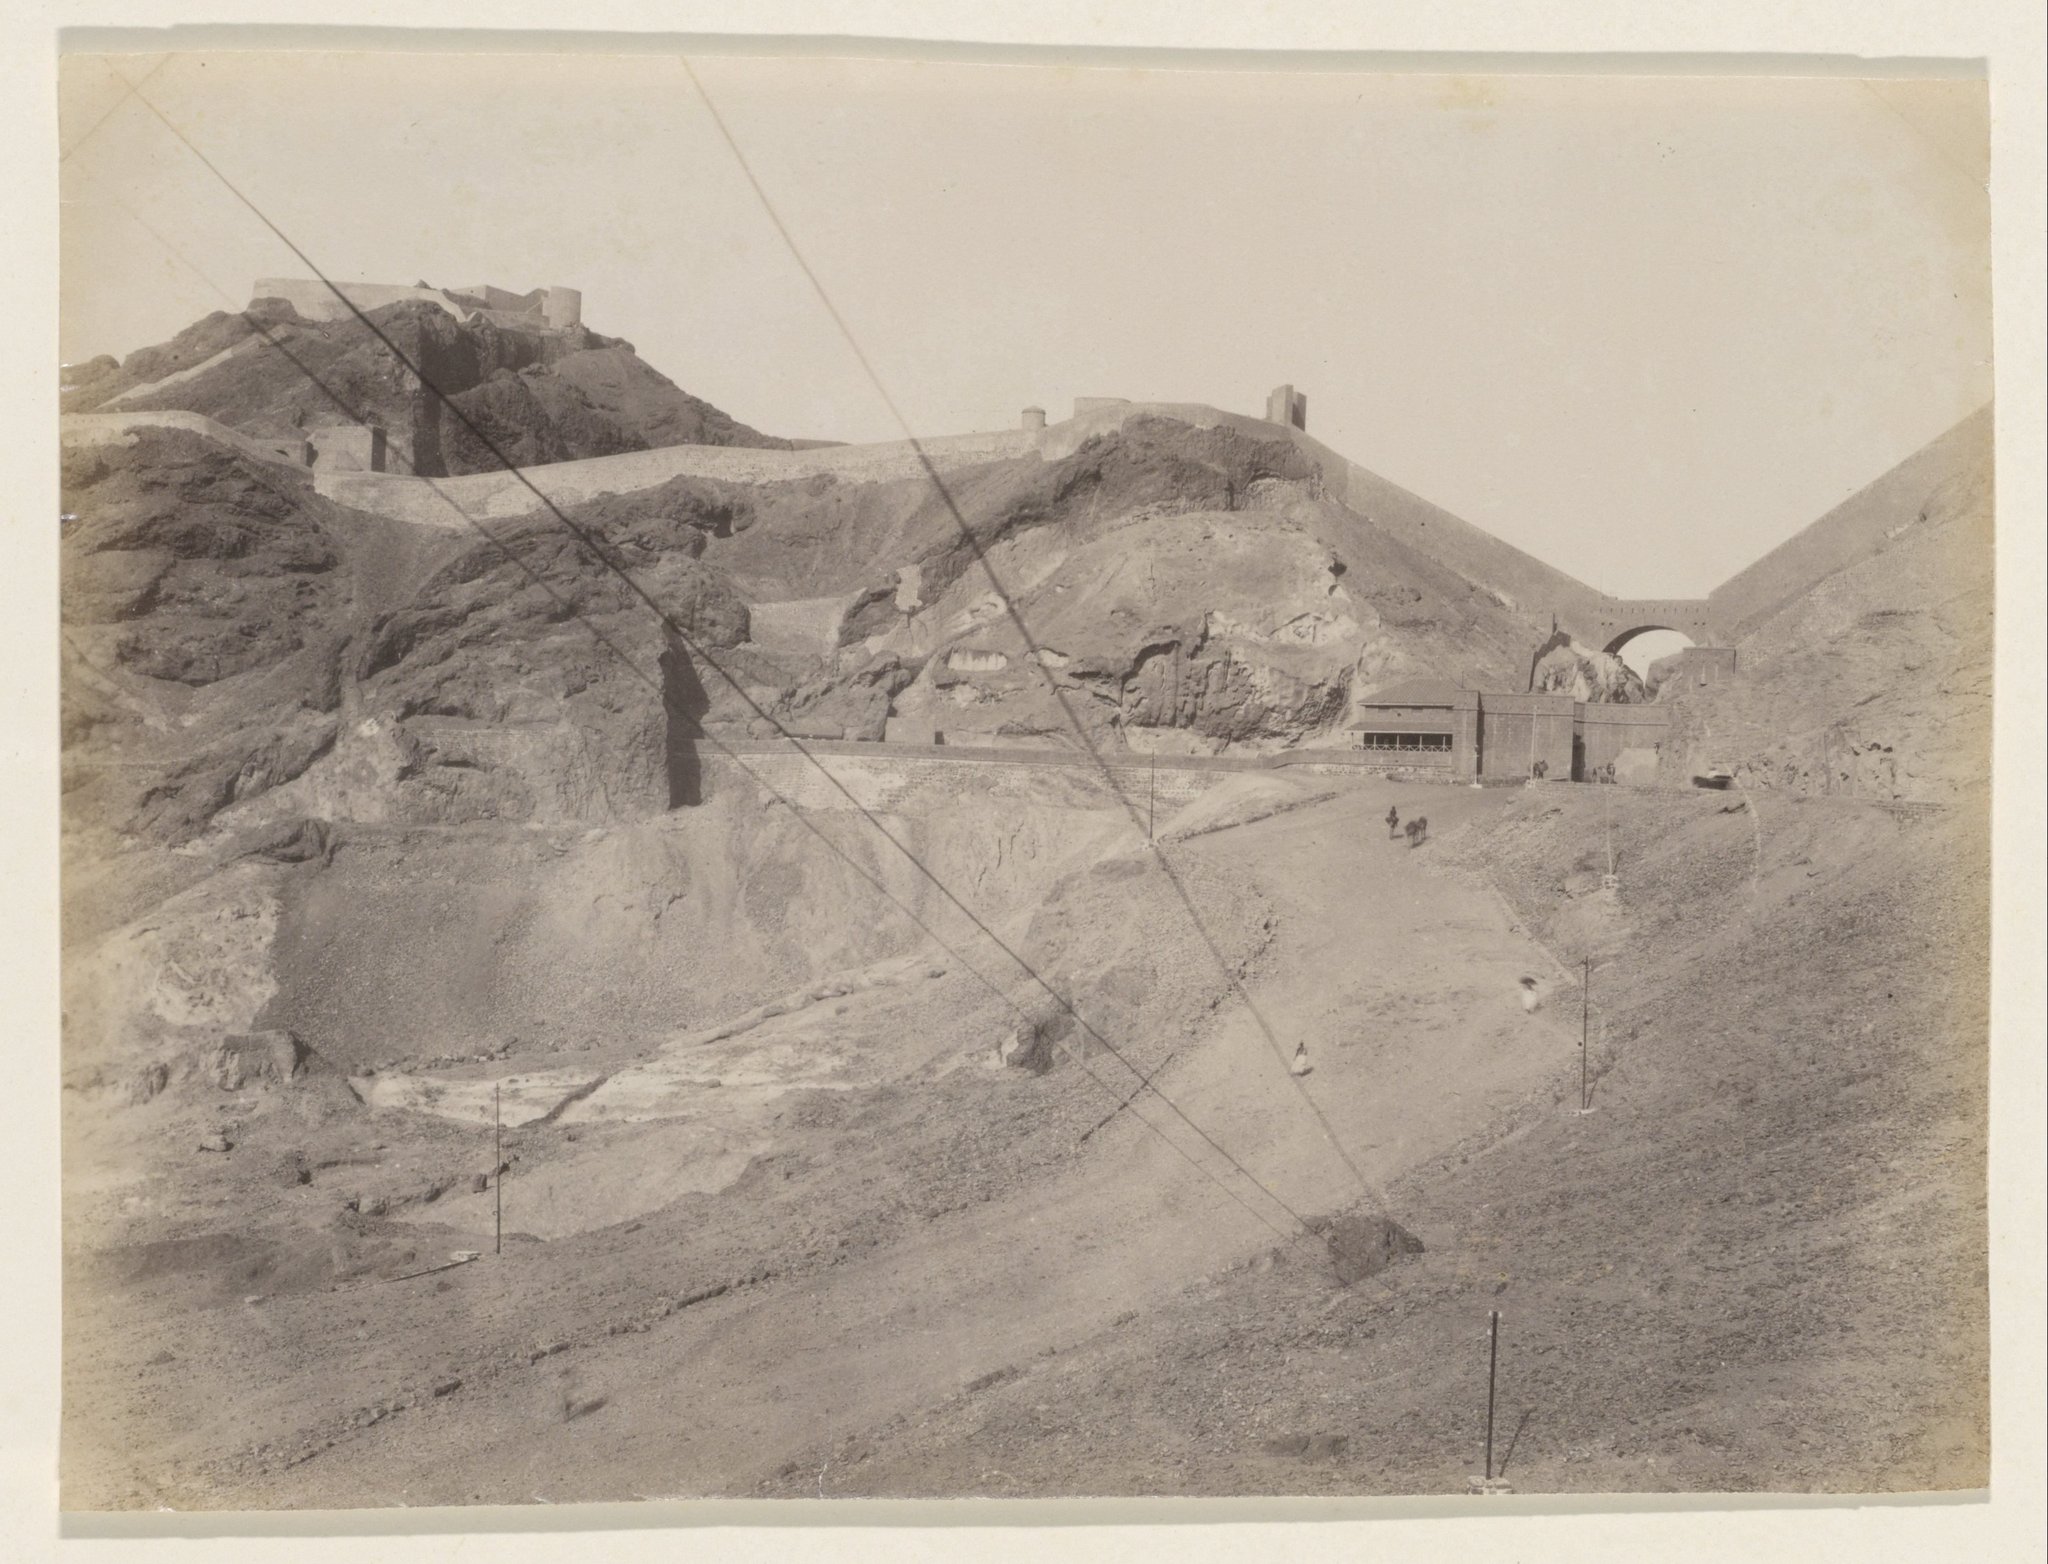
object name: photograph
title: Gezicht op een fort op een berg in Aden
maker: Anonymous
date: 1860-1900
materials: paper, photographic support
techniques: albumen print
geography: aden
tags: fortress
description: Onderdeel van Fotoalbum van een reis door de Verenigde Staten, Honolulu, Nederlands-Indië, Aden, Zanzibar en Zuidelijk Afrika.